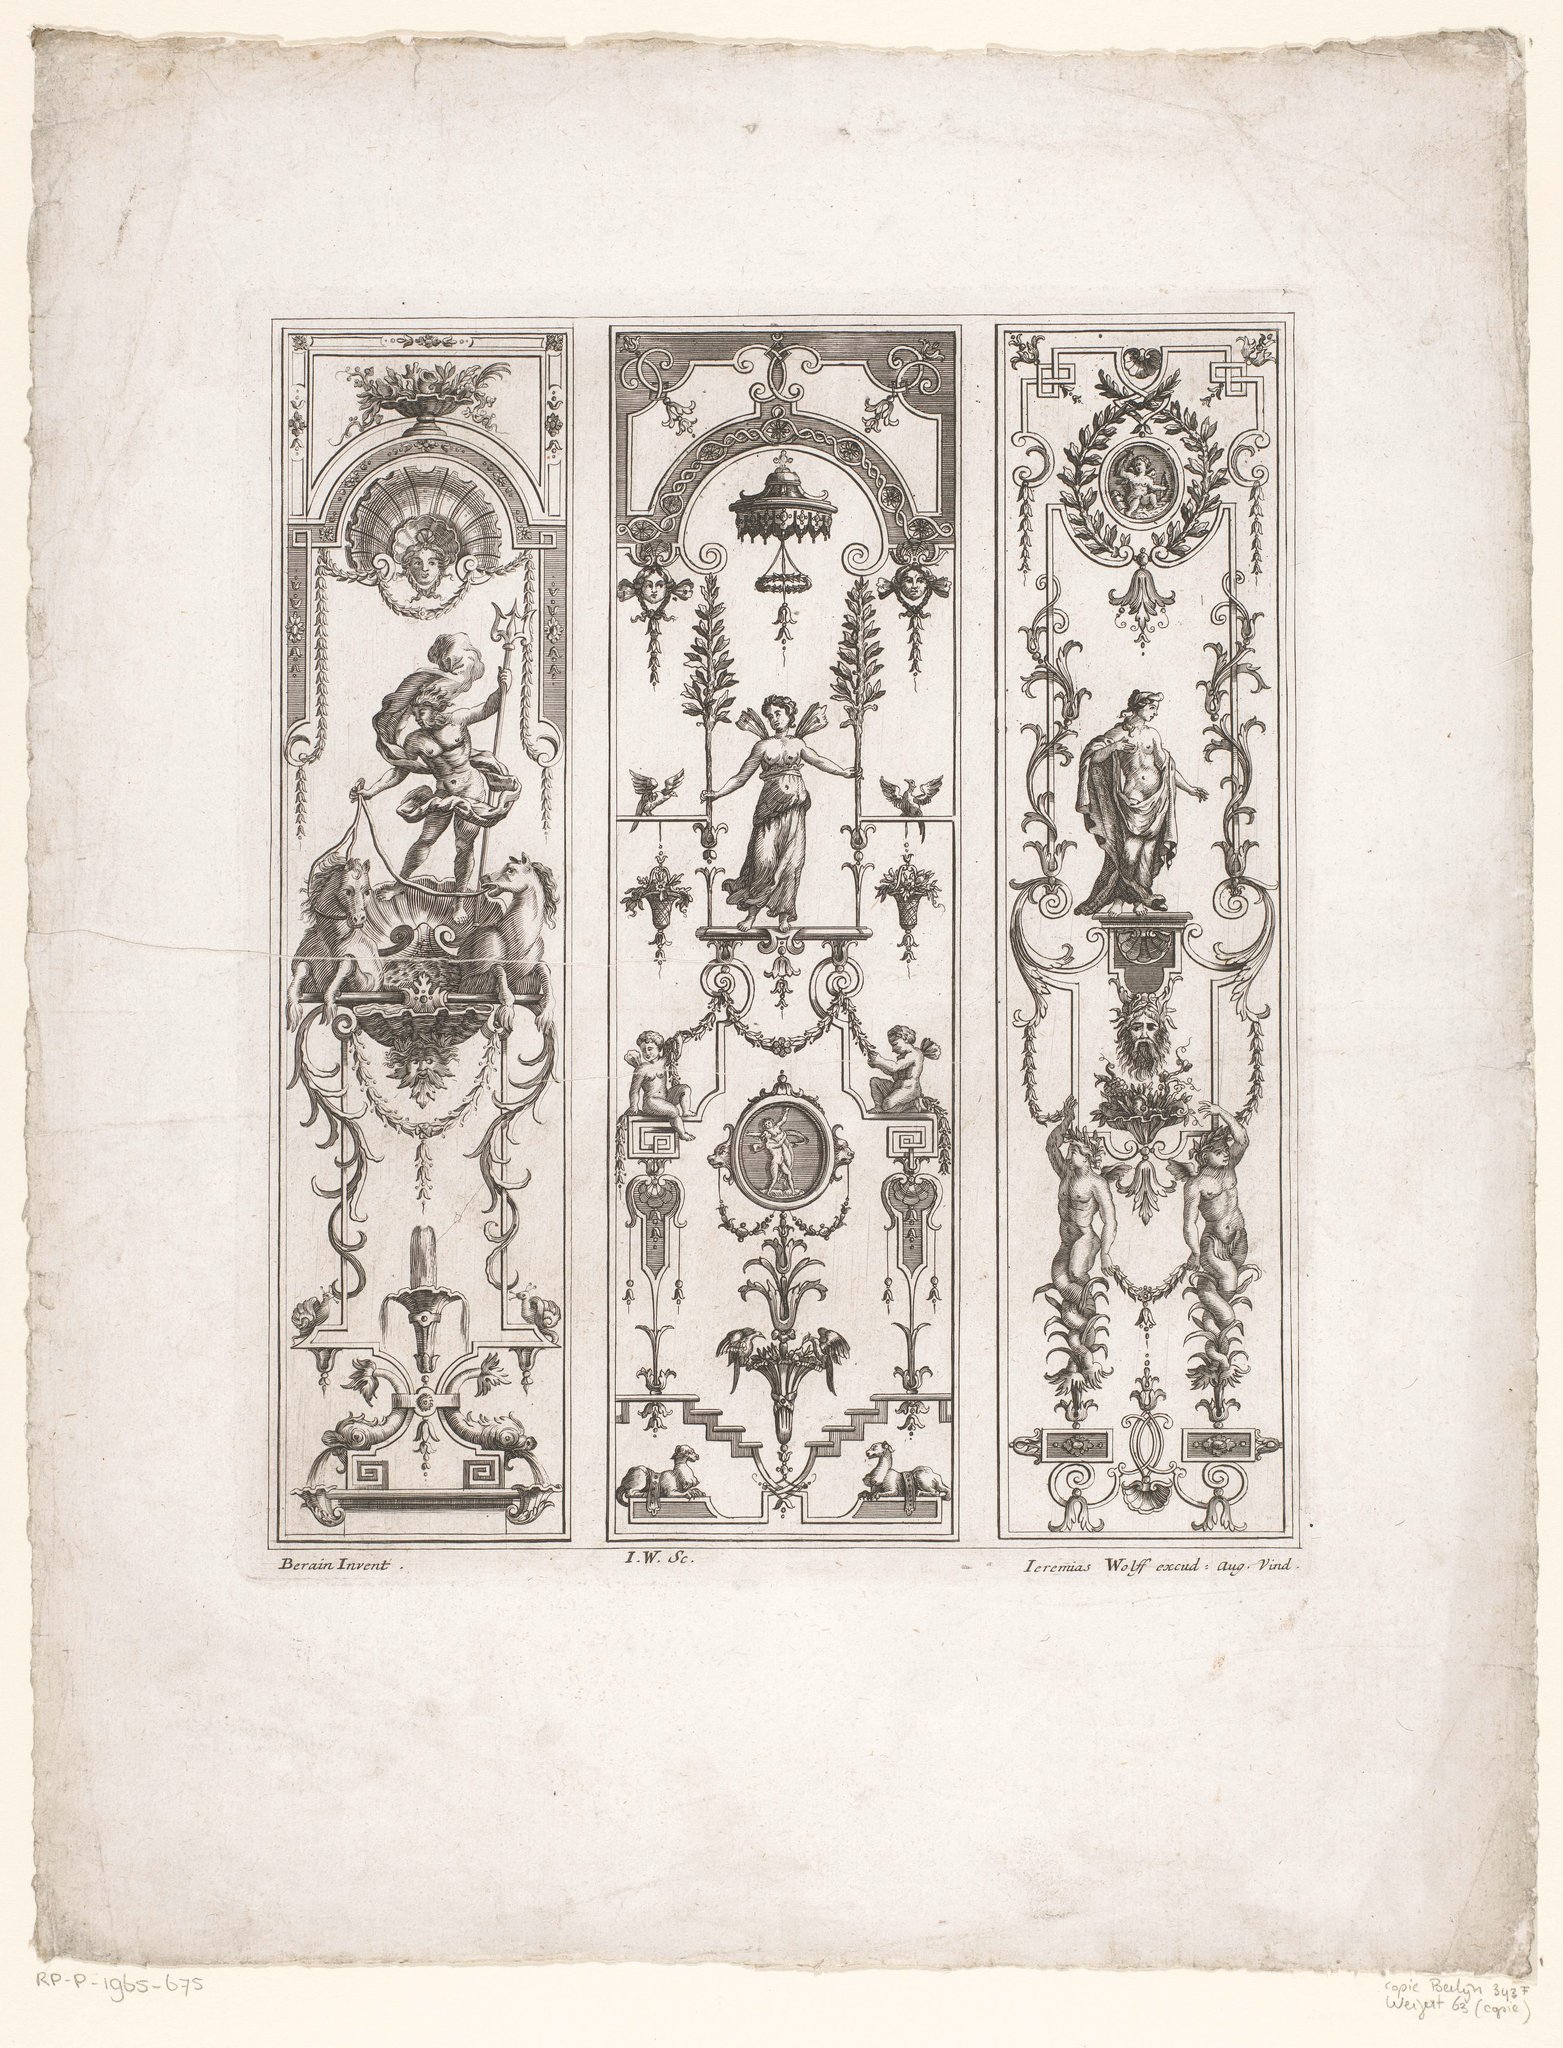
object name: ornament print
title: Compositie met Neptunus en twee vrouwen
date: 1686-1724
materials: paper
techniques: etching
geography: augsburg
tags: (story of) neptune (poseidon), frequently used ornamental compositions, standing figure - aa - female human figure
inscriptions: collector's mark: Lugt 2228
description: Een decoratieve compositie bestaand uit drie panelen met vlechtwerk. Links staat Neptunus op zijn strijdwagen voortgetrokken door twee paarden. In het midden staat een gevleugelde vrouw onder een baldakijn. Onder haar twee putti en een medaillon met Amor en Psyche. Rechts staat een vrouw met gedrapeerd doek op een voetstuk gedragen door twee mannelijke figuren.